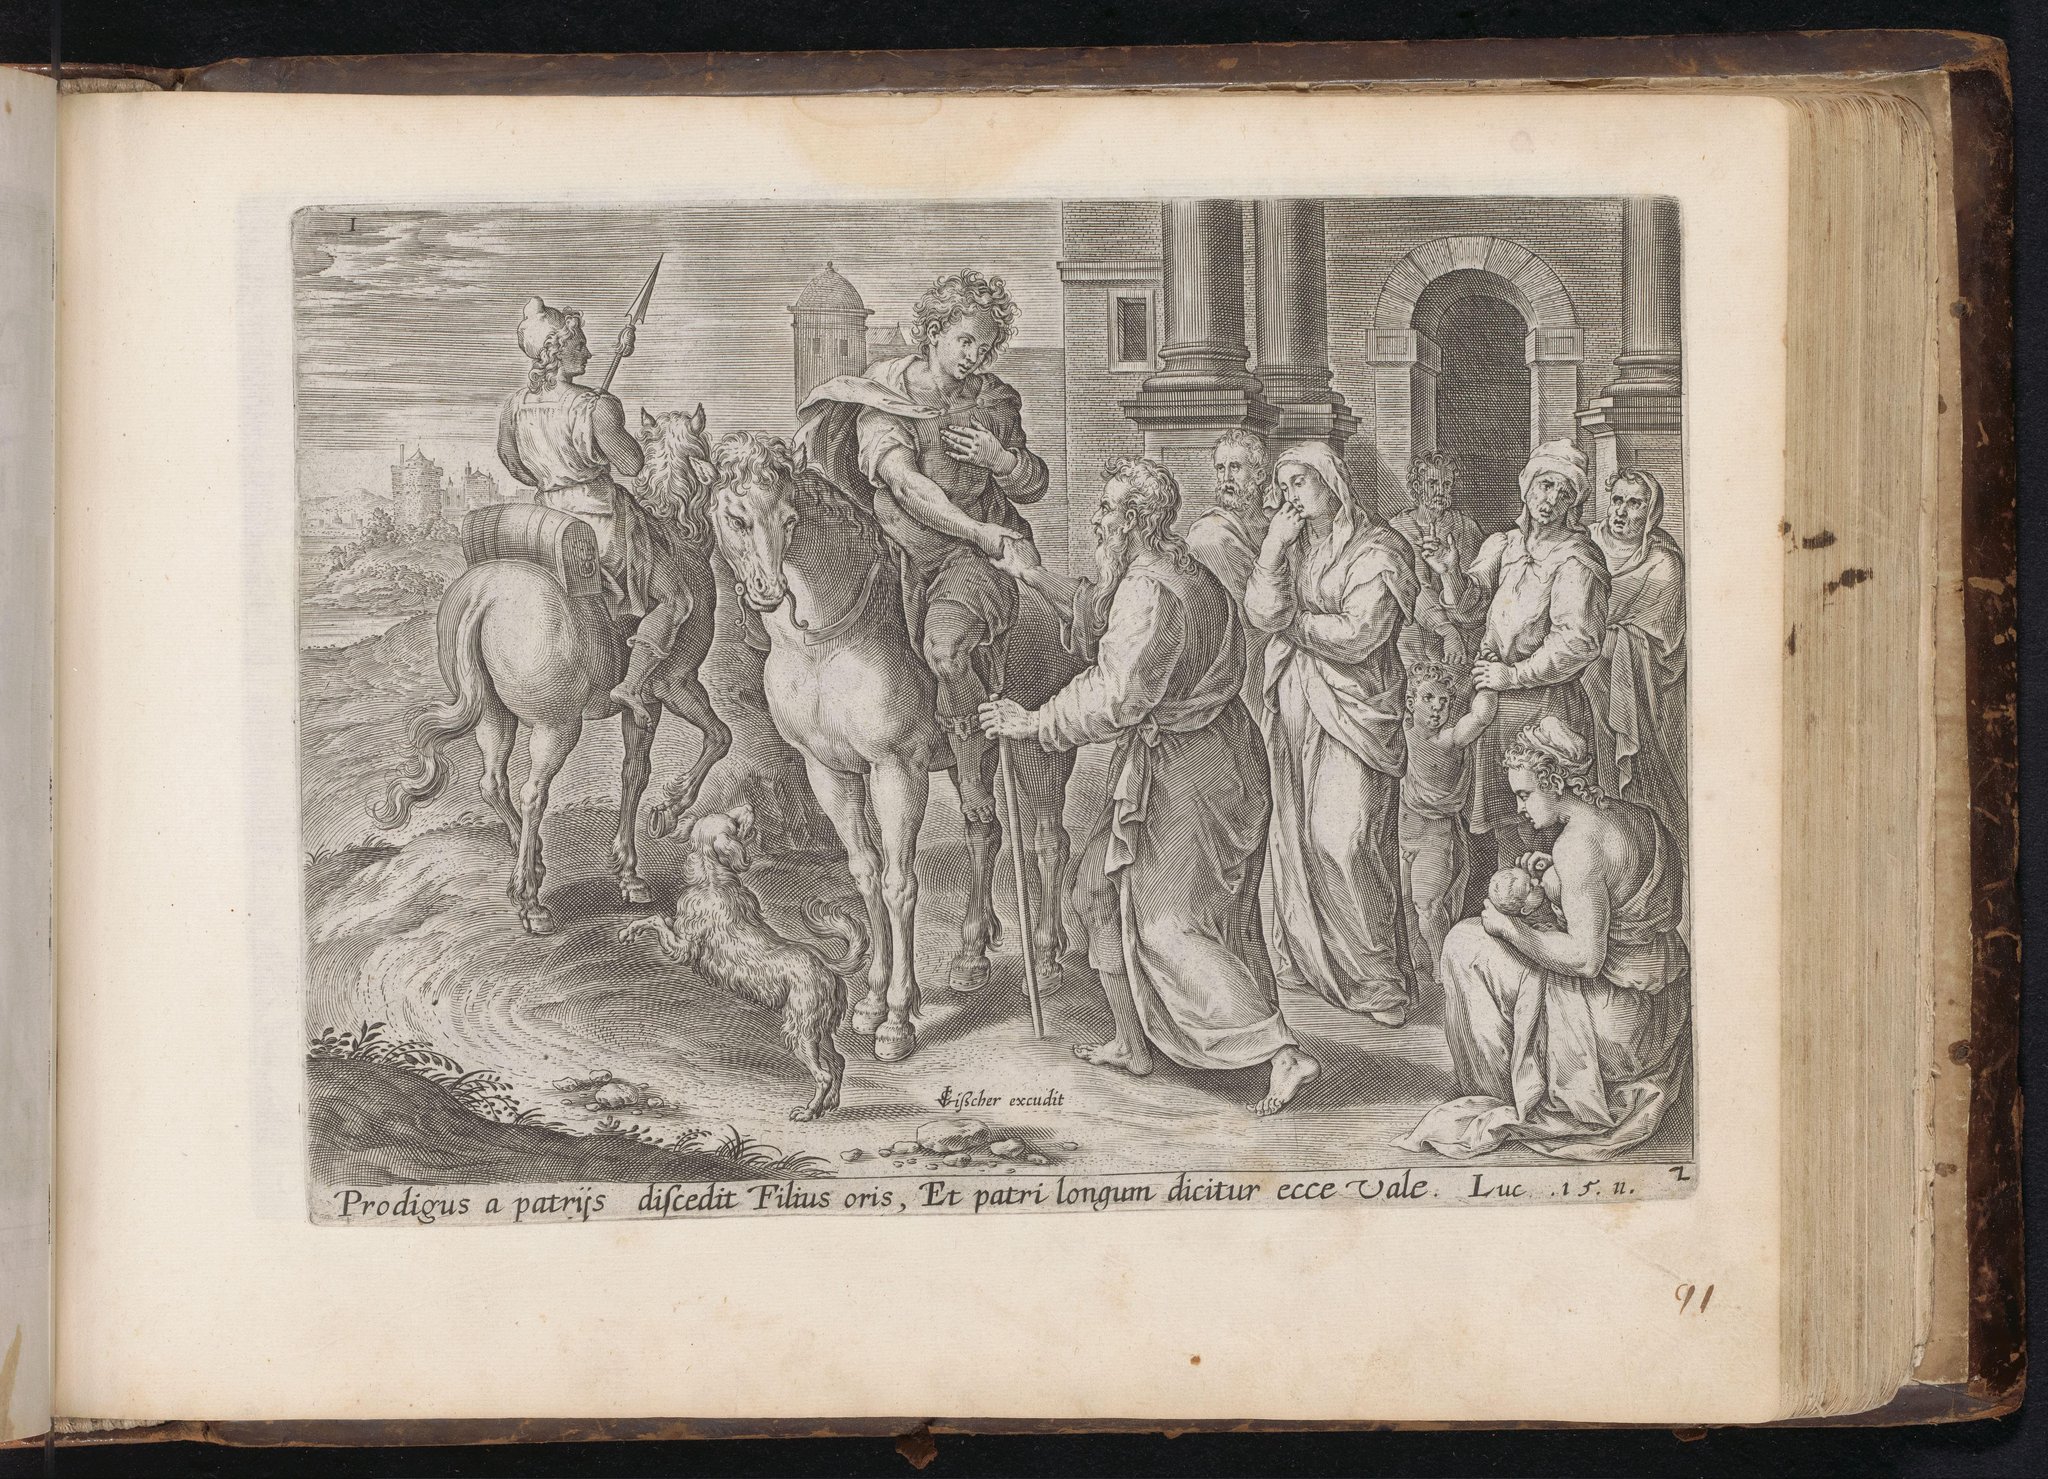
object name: print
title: De verloren zoon neemt afscheid van zijn vader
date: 1585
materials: paper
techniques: engraving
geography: alkmaar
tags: leave-taking and departure of the prodigal son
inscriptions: number: ‘91’, serial number: ‘2’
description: De verloren zoon neemt afscheid van zijn vader. Hij zit te paard en schudt zijn vader de hand. Rechts de familie voor het huis. Onder de voorstelling een verwijzing in het Latijn naar de Bijbeltekst in Luc. 15:11. Deze prent maakt deel uit van een album.